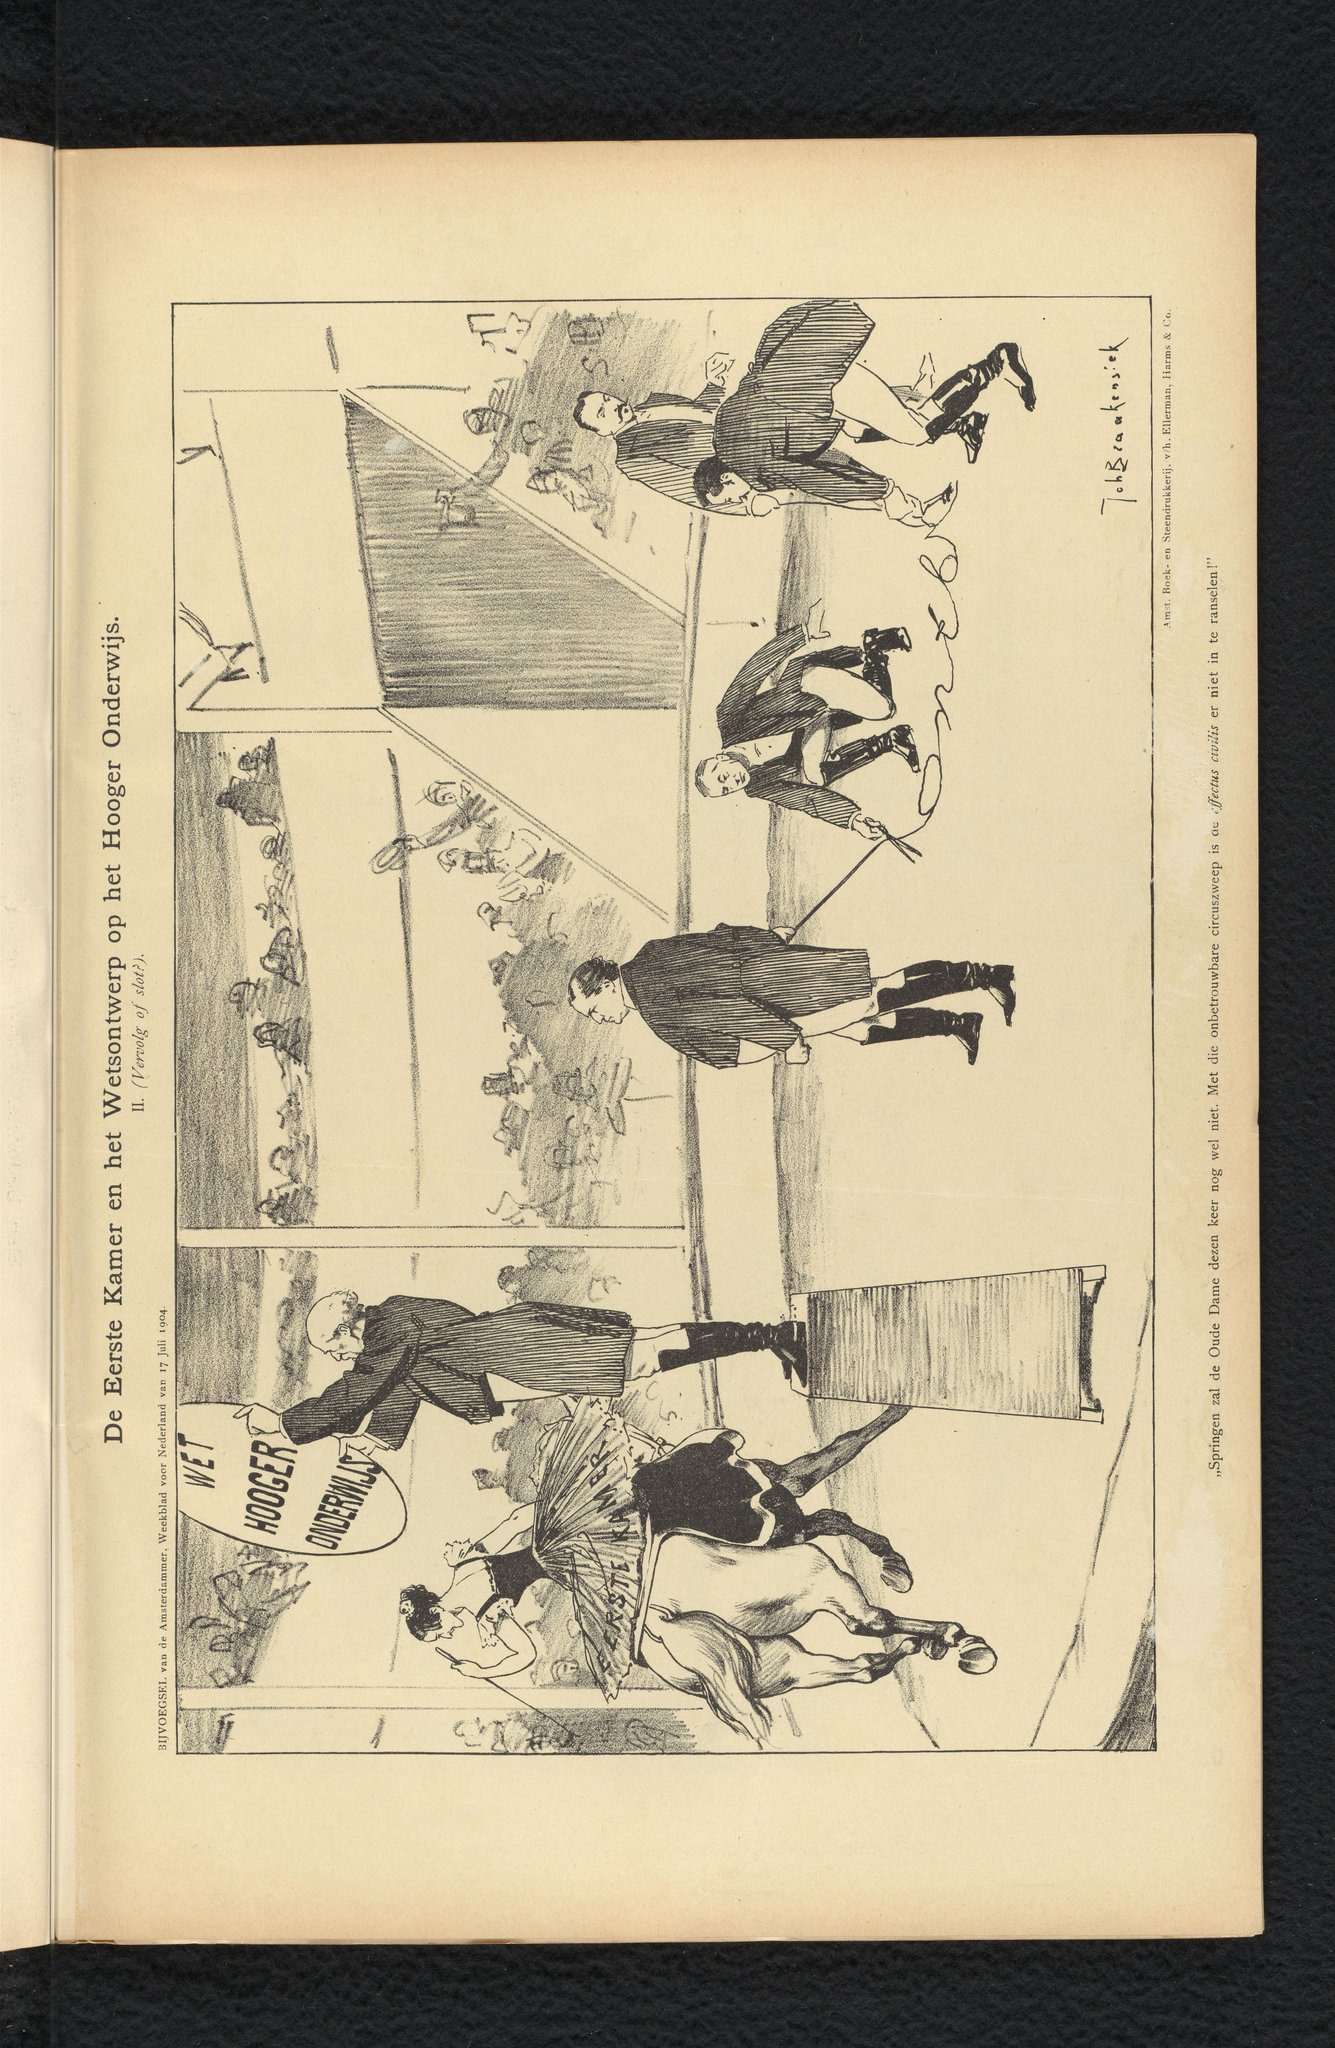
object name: cartoon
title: De Eerste Kamer en het Wetsontwerp op het Hooger Onderwijs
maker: johan braakensiek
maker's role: draughtsman, print maker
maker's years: 1858-1940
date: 1904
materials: paper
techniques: lithograph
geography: amsterdam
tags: the hague, abraham kuyper, boss, director (of circus), horses (circus performance), circus ring, political caricatures and satires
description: Premier Kuyper als circusdirecteur met een zweep ziet dat de Eerste Kamer, een oude dame staande op een paard, niet door de hoepel van de 'Wet Hooger Onderwijs' springt. Twee mannen knippen de zweep kort. Vervolg op de prent van 26 juni.